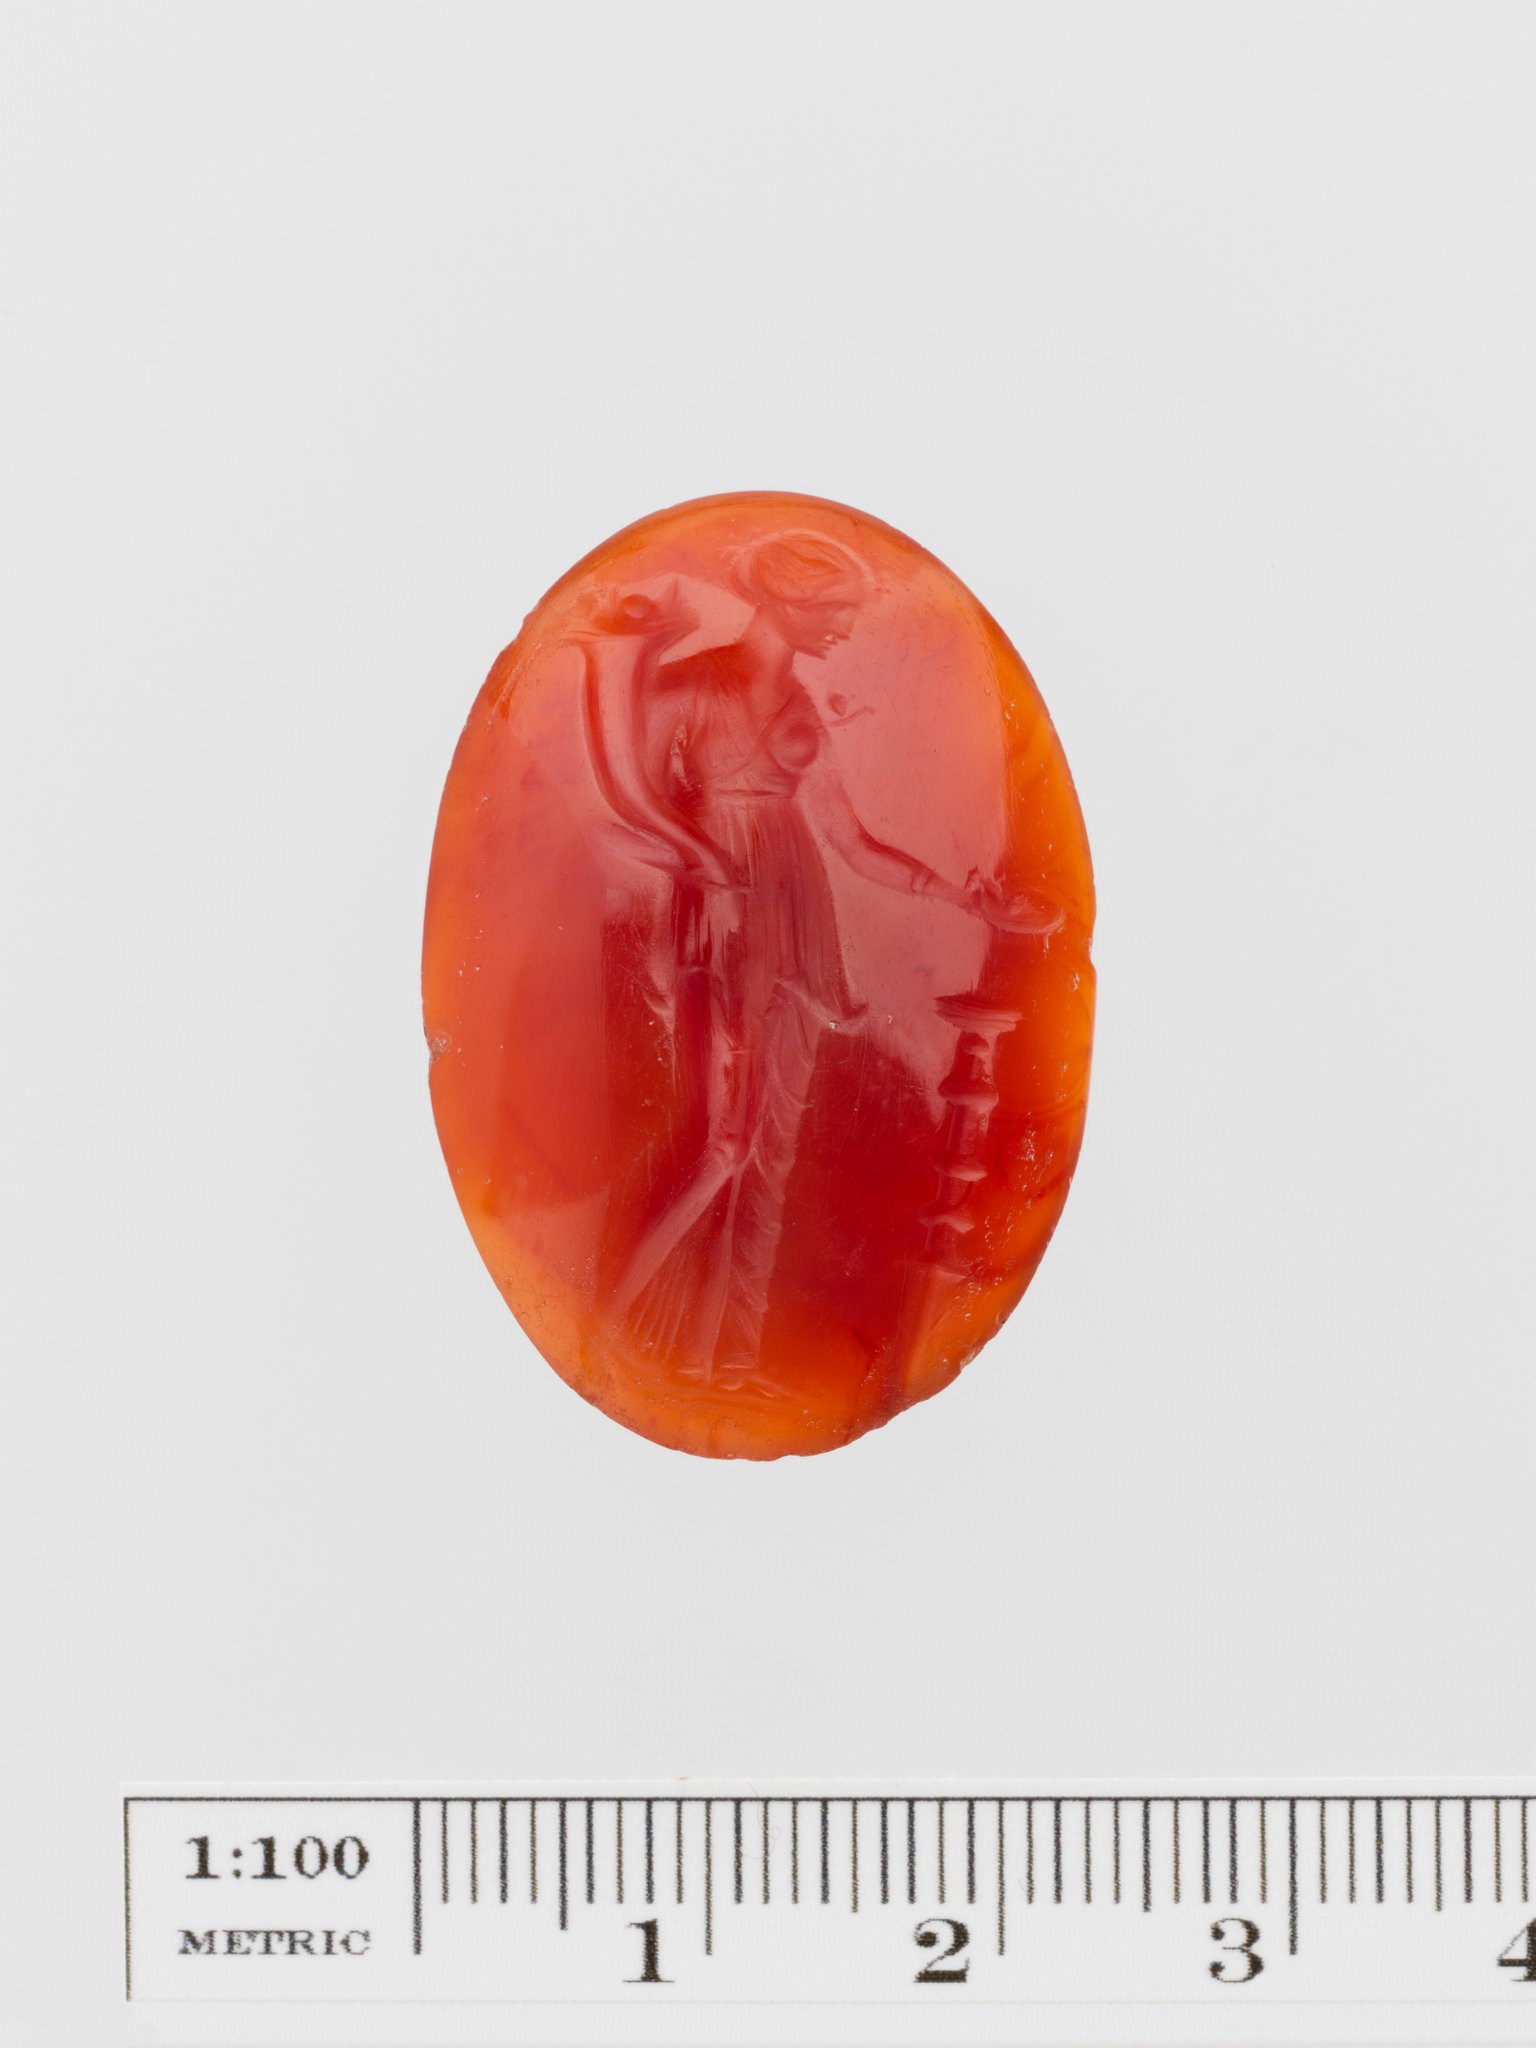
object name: intaglio of artemis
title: Sard oval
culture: greek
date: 300-201 BCE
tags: artemis,cornucopia